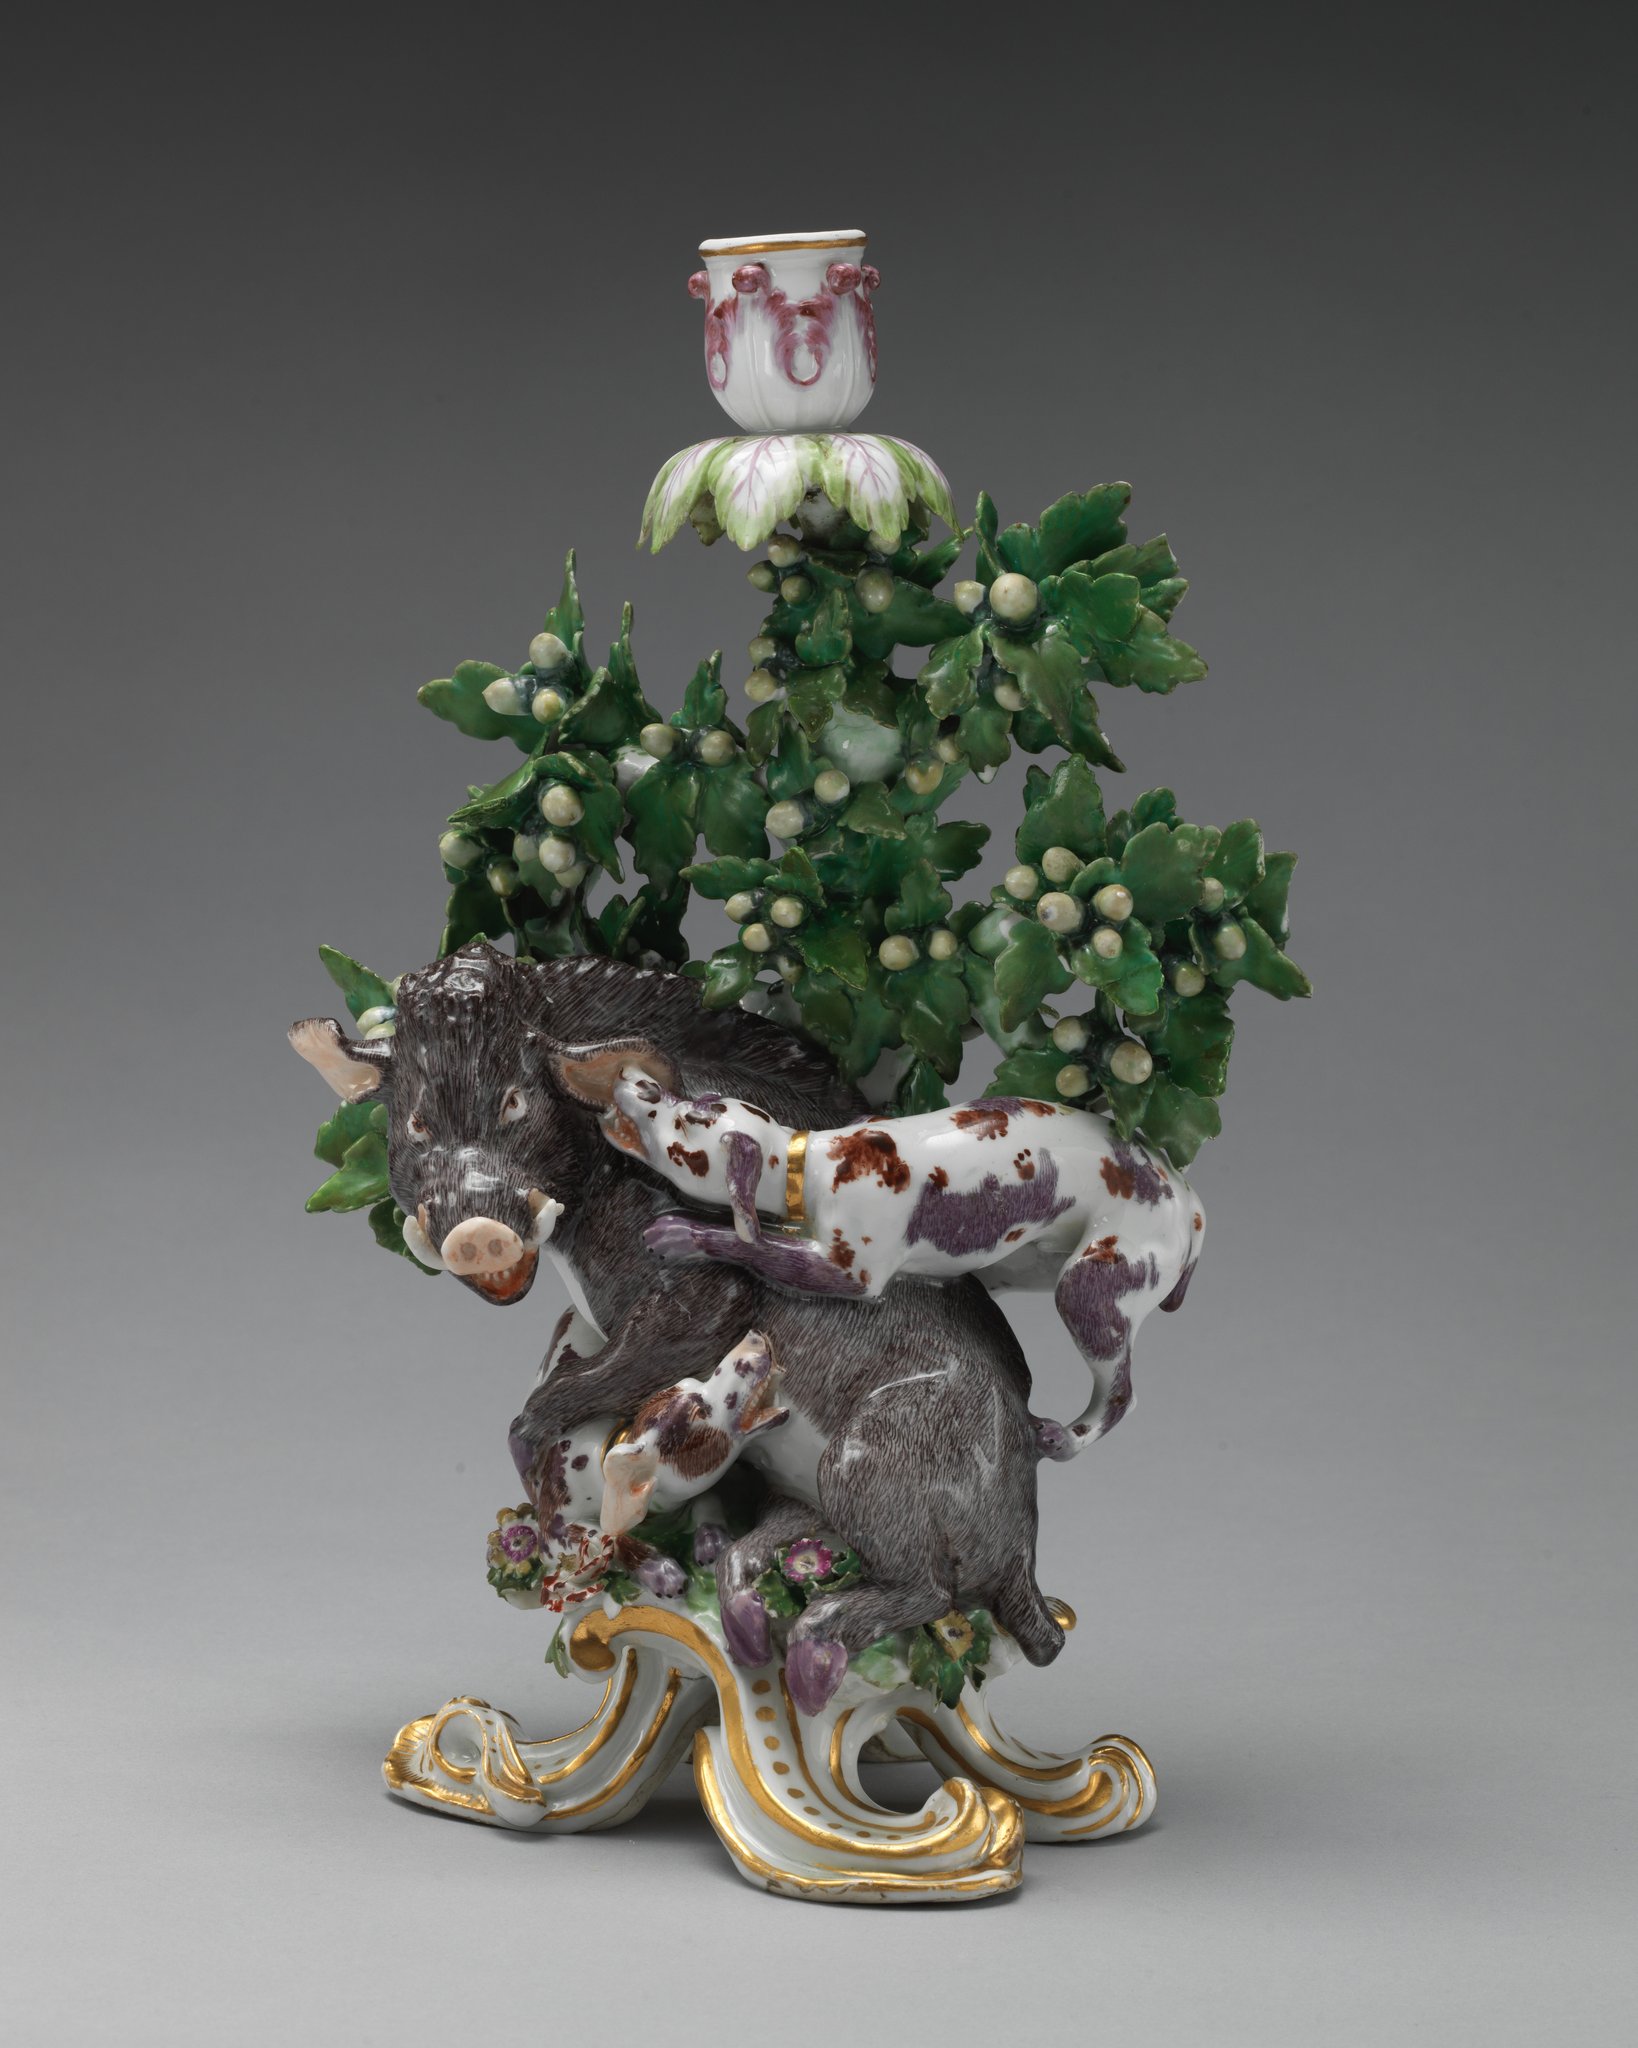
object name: candlestick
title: Candlestick (one of a pair)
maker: chelsea porcelain manufactory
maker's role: factory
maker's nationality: british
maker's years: 1744-1784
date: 1760-1765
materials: soft paste porcelain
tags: boars,dogs,leaves